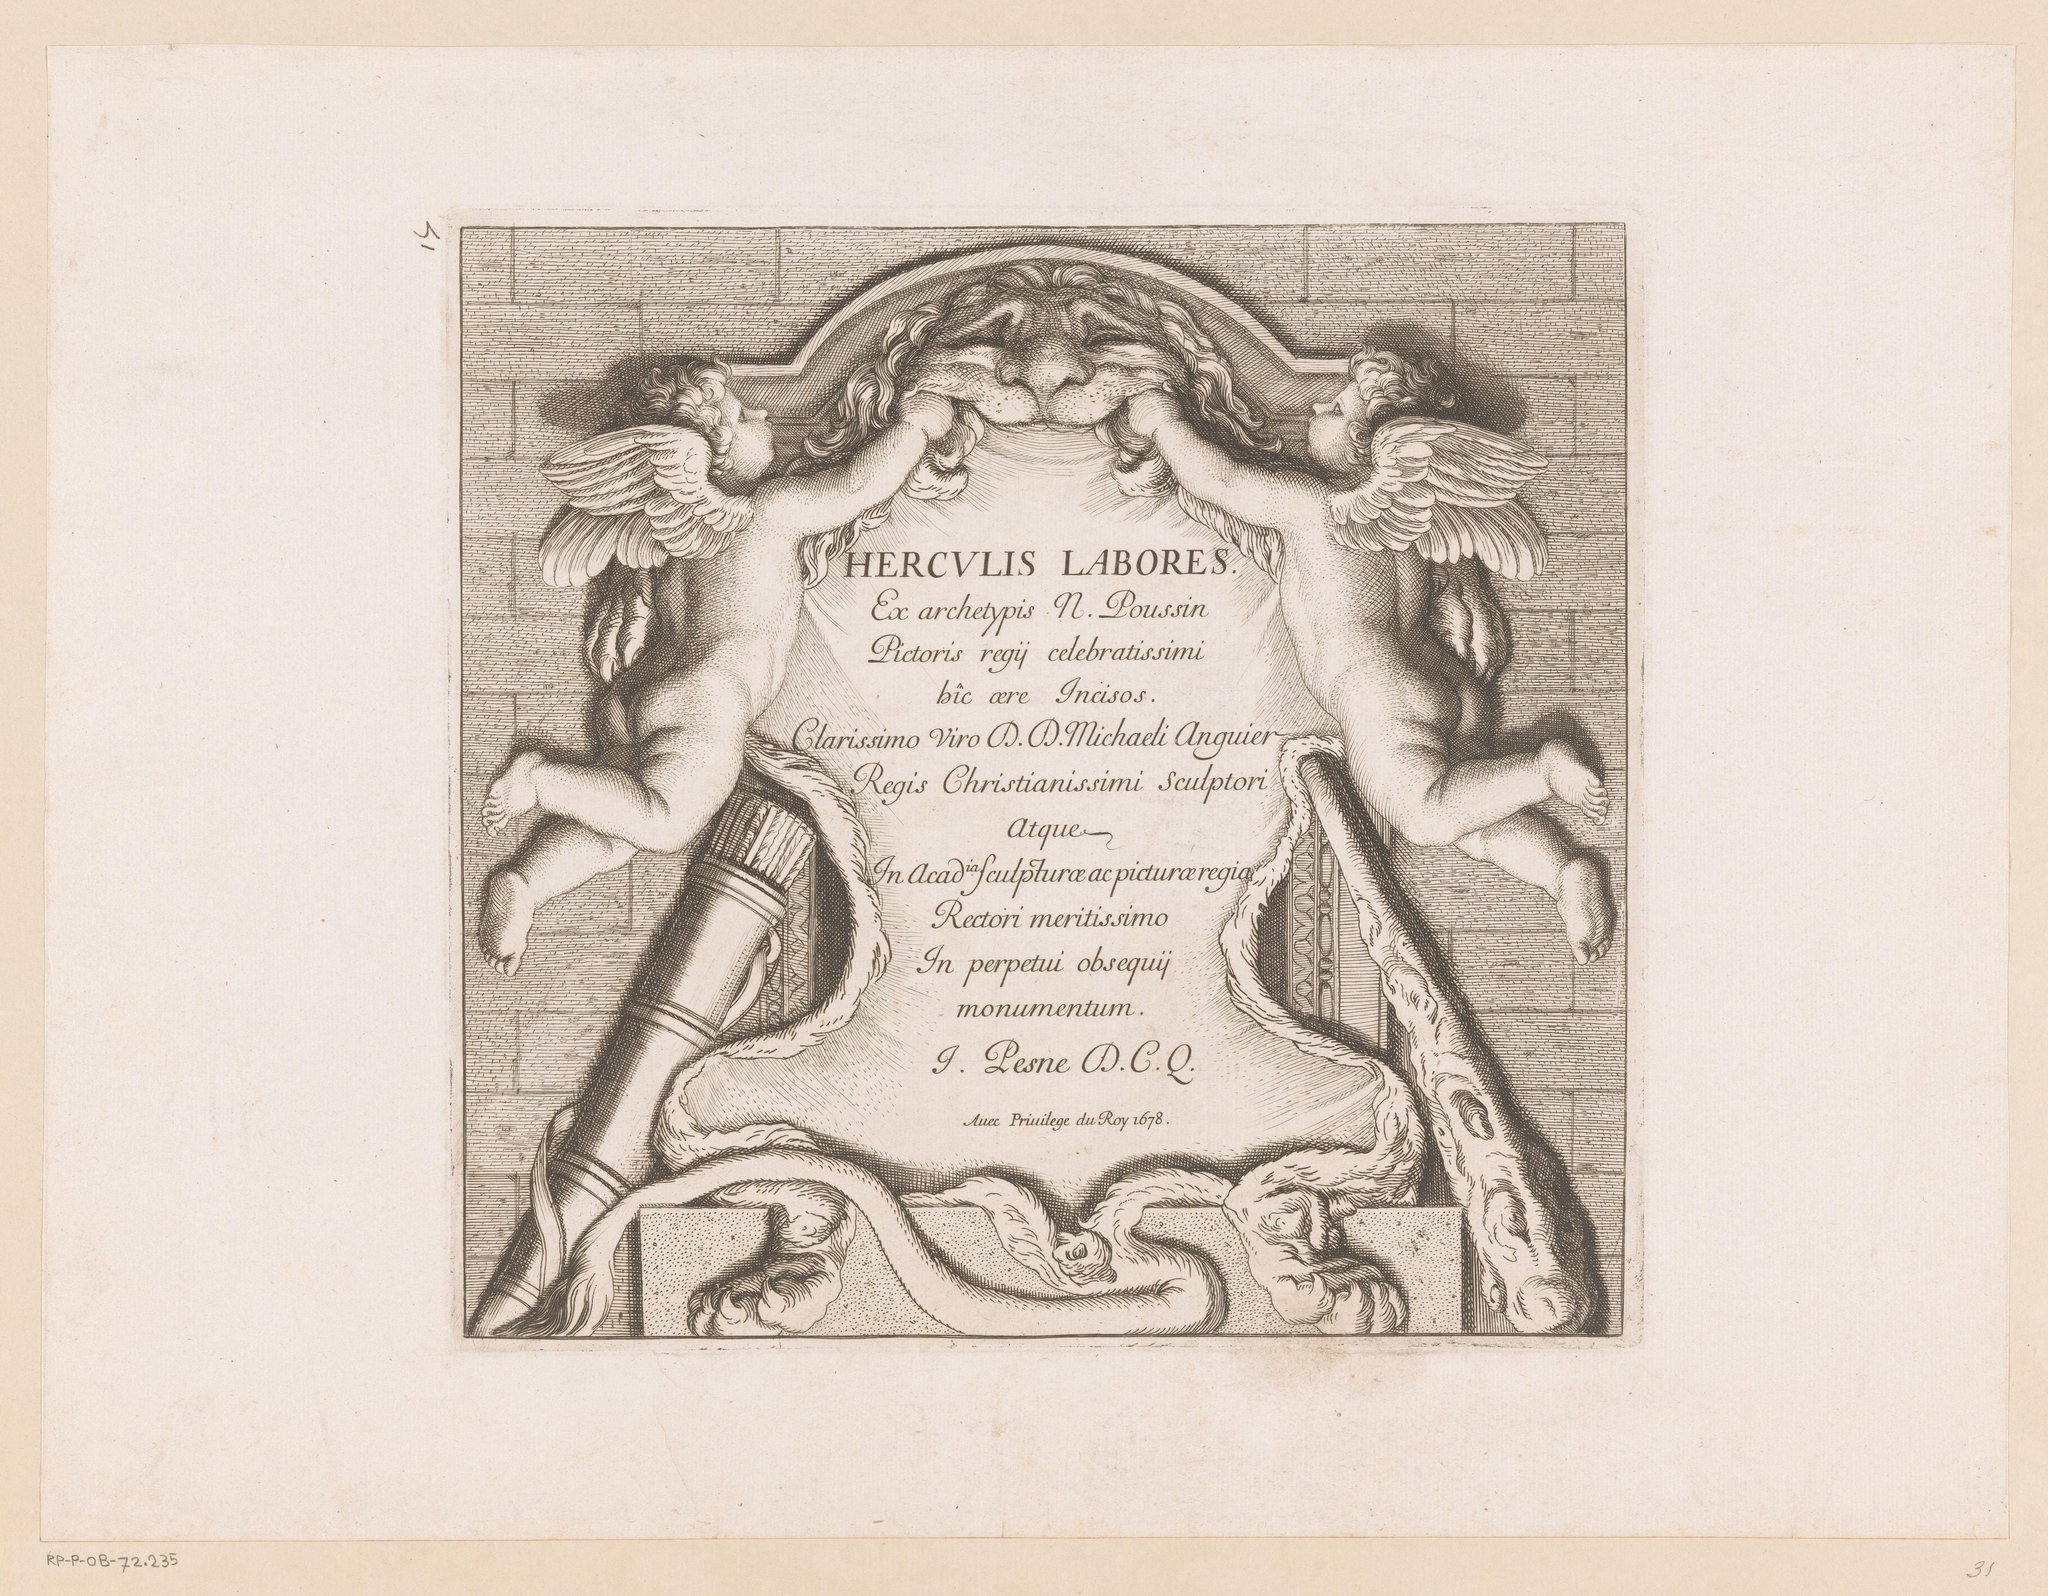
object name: print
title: Herculis Labores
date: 1678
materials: paper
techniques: engraving, etching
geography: france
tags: attributes of hercules, cupids: 'amores', 'amoretti', 'putti'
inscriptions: collector's mark: Lugt 240